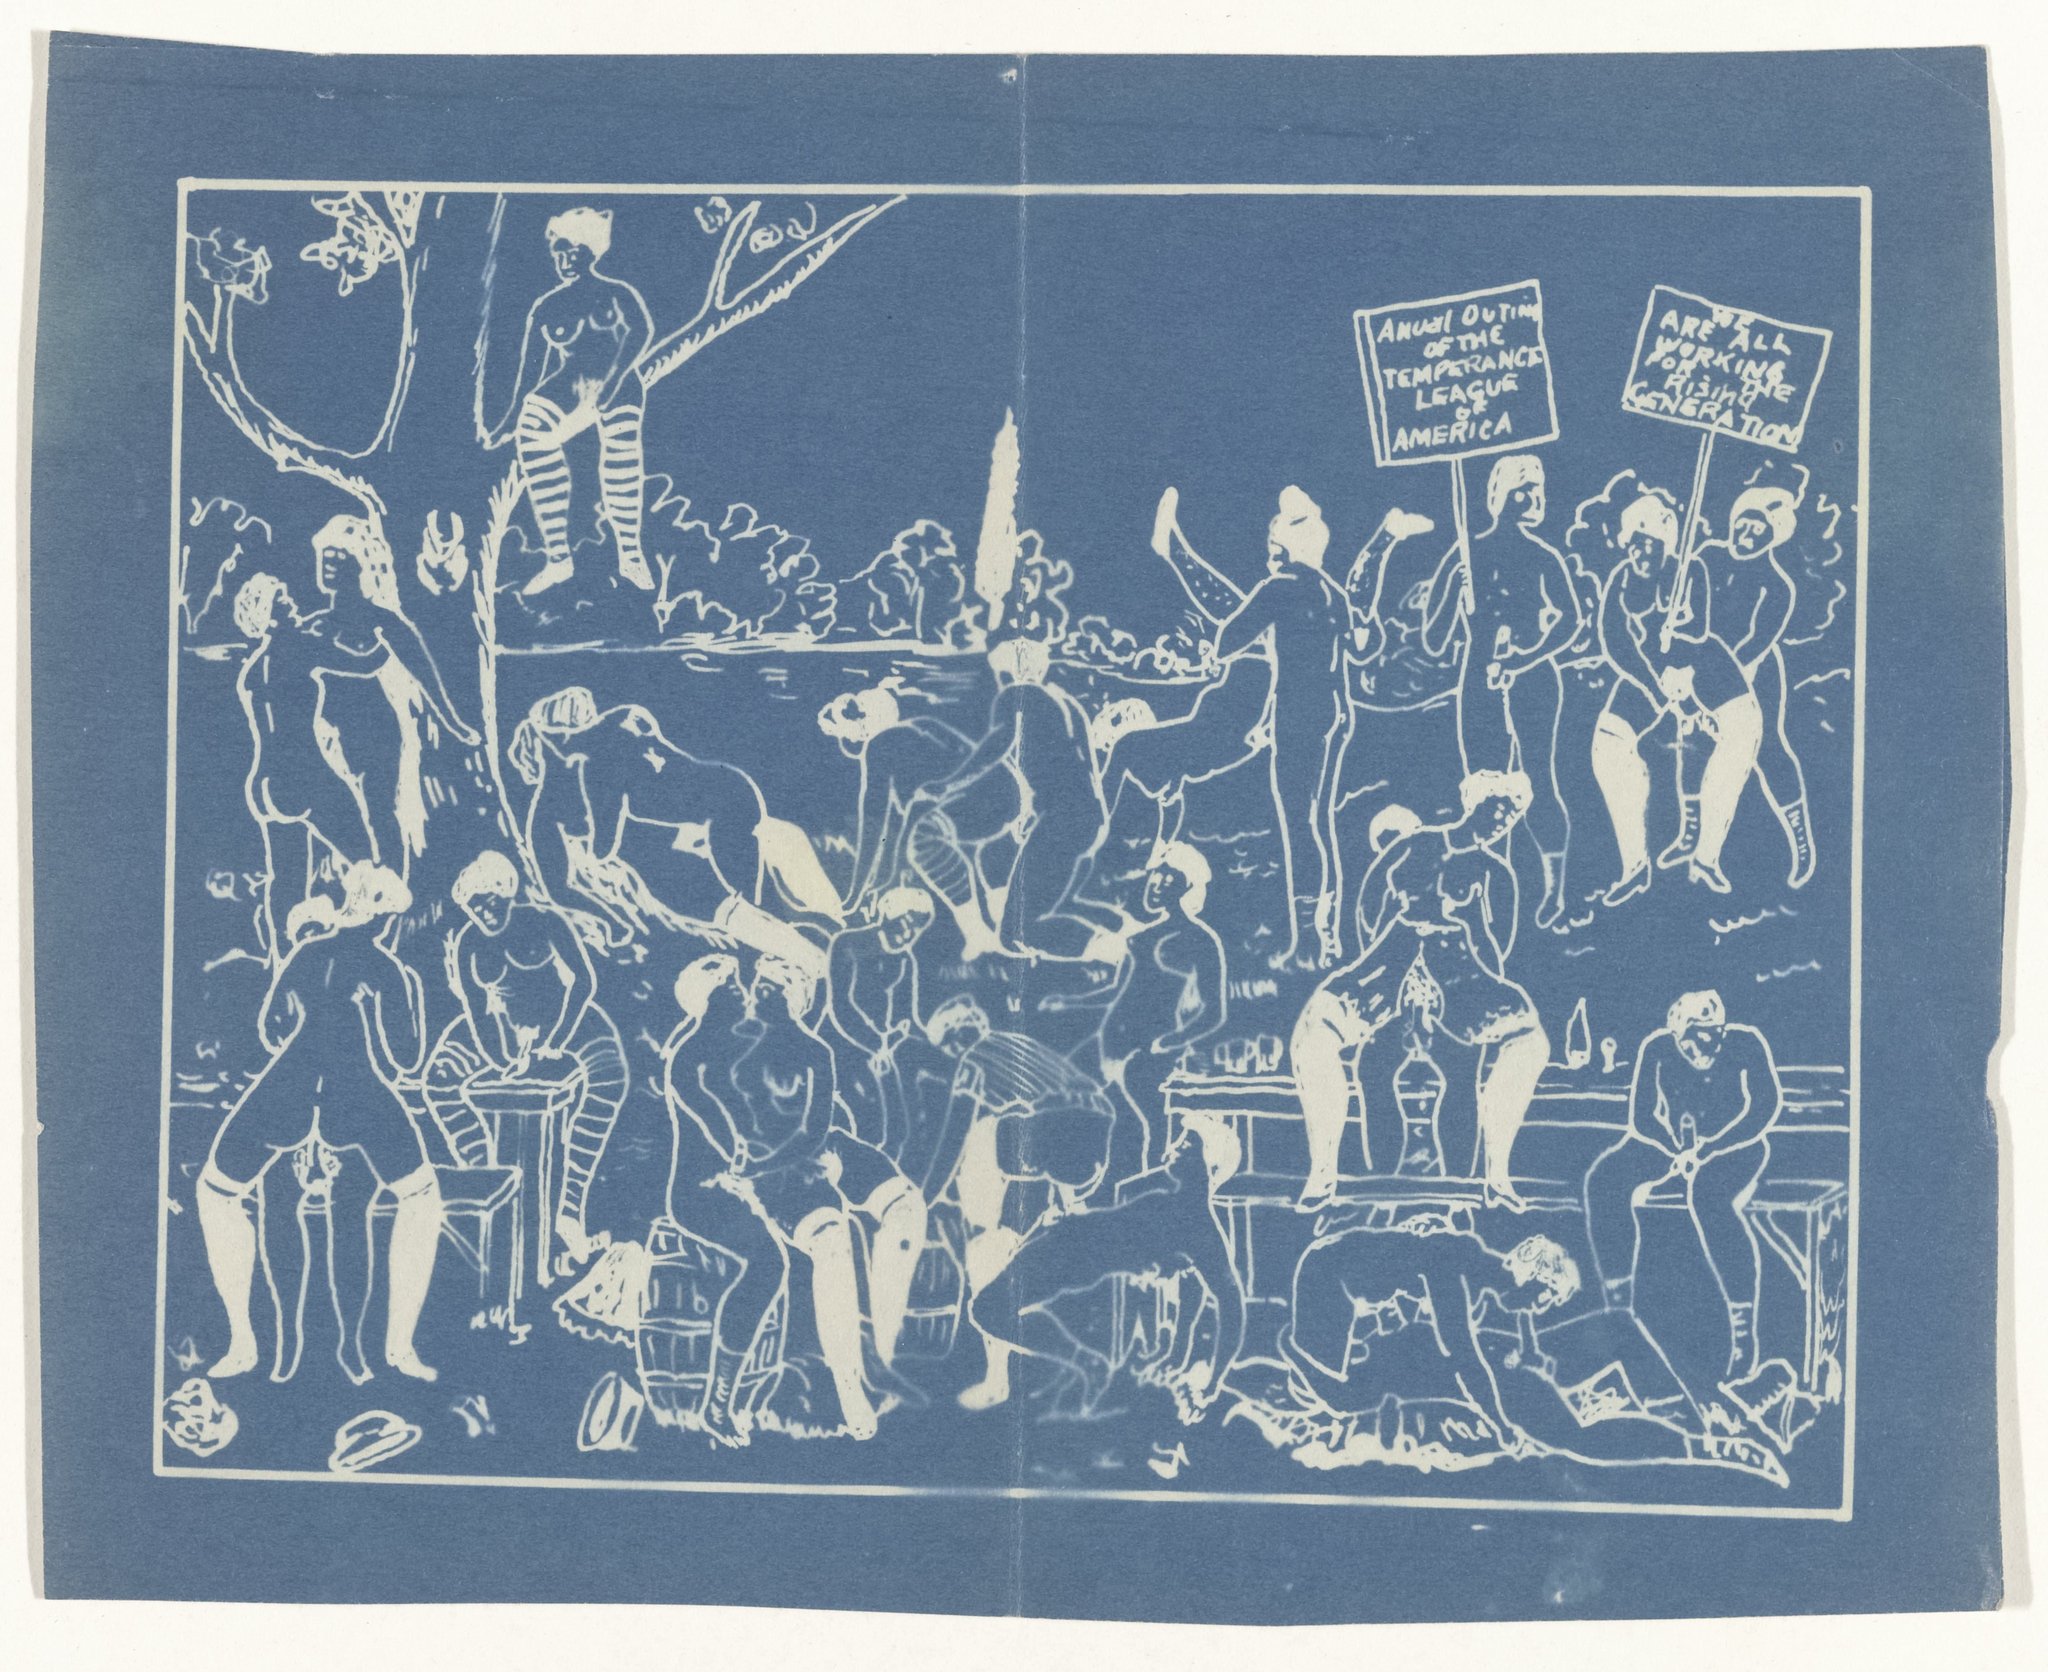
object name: photograph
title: Fotoreproductie van risqué onderwerp, tekening van een orgie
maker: Anonymous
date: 1900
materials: paper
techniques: cyanotype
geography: united states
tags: scabrous scenes, pornography, carousal, drinking-bout, orgy - cc - out of doors, group-sex, promiscuity, fantasies of a world of free love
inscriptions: inscription: ‘we/ are all/ working/ for the/ rising/ generation’